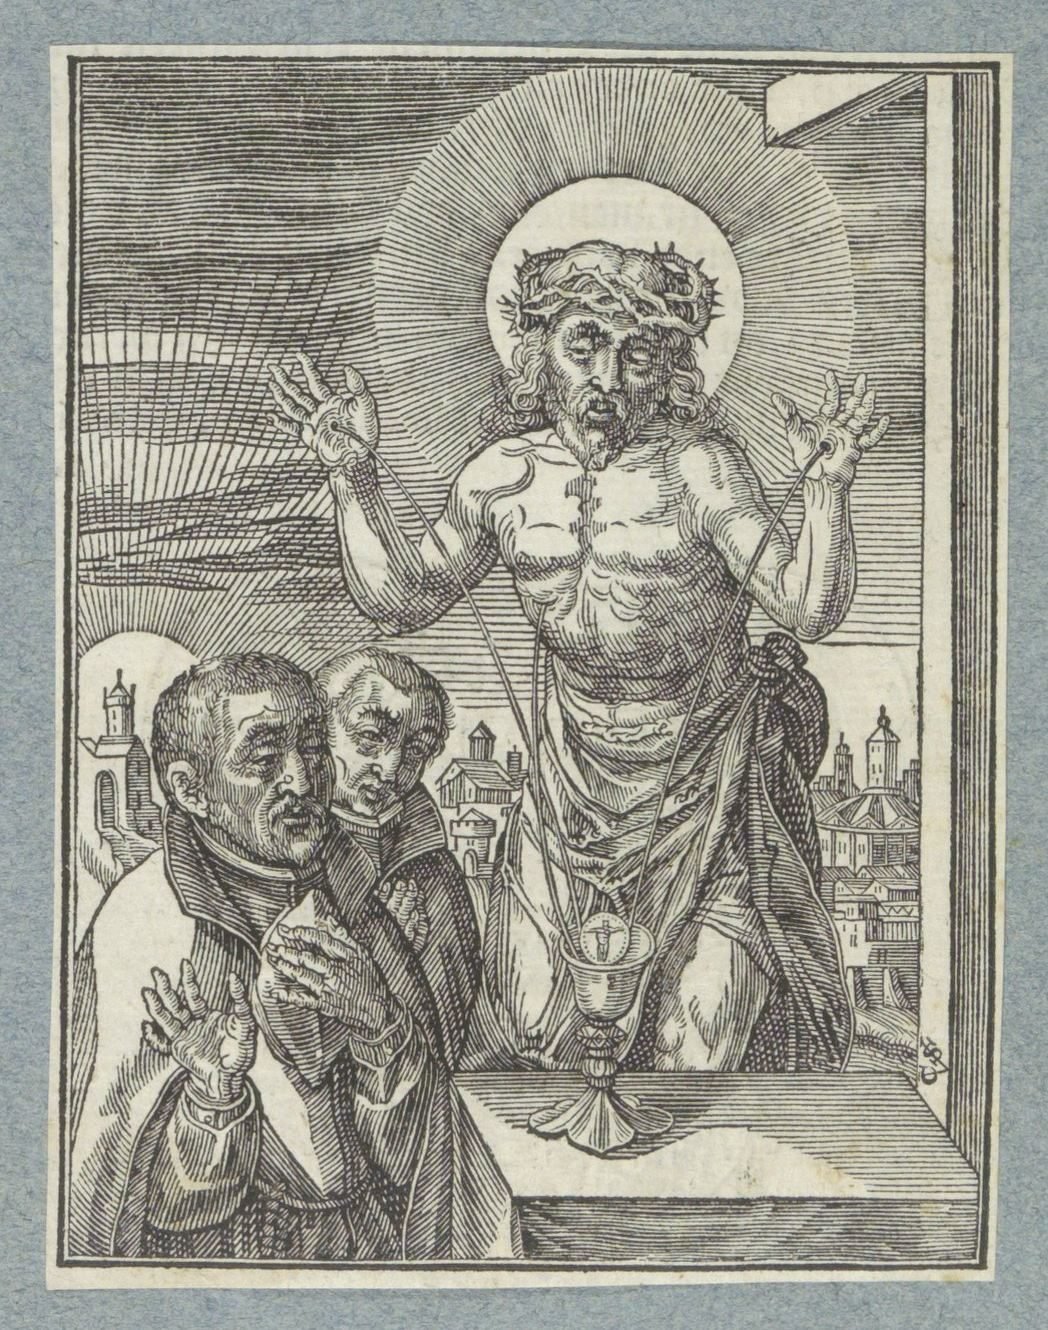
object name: book illustration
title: Bloed van Christus opgevangen in miskelk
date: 1629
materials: paper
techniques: letterpress printing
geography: amsterdam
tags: rome, clergyman, blood spouting from christ's wounds, the founder of the jesuit order, ignatius of loyola; possible attributes: book (with 'ad majorem dei gloriam'), demon, dragon under feet, flames, flaming heart, globe, ihs monogram, skull (with crown), tears in eyes, torch, male saints (with name)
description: Christus staat met geheven handen naast het kruis. Het bloed uit zijn kruiswonden stroomt in een miskelk. De Jezuïeten Ignatius van Loyola en Stanislaus Kostka kijken vol ontzag toe. De prent maakt deel uit van een album.